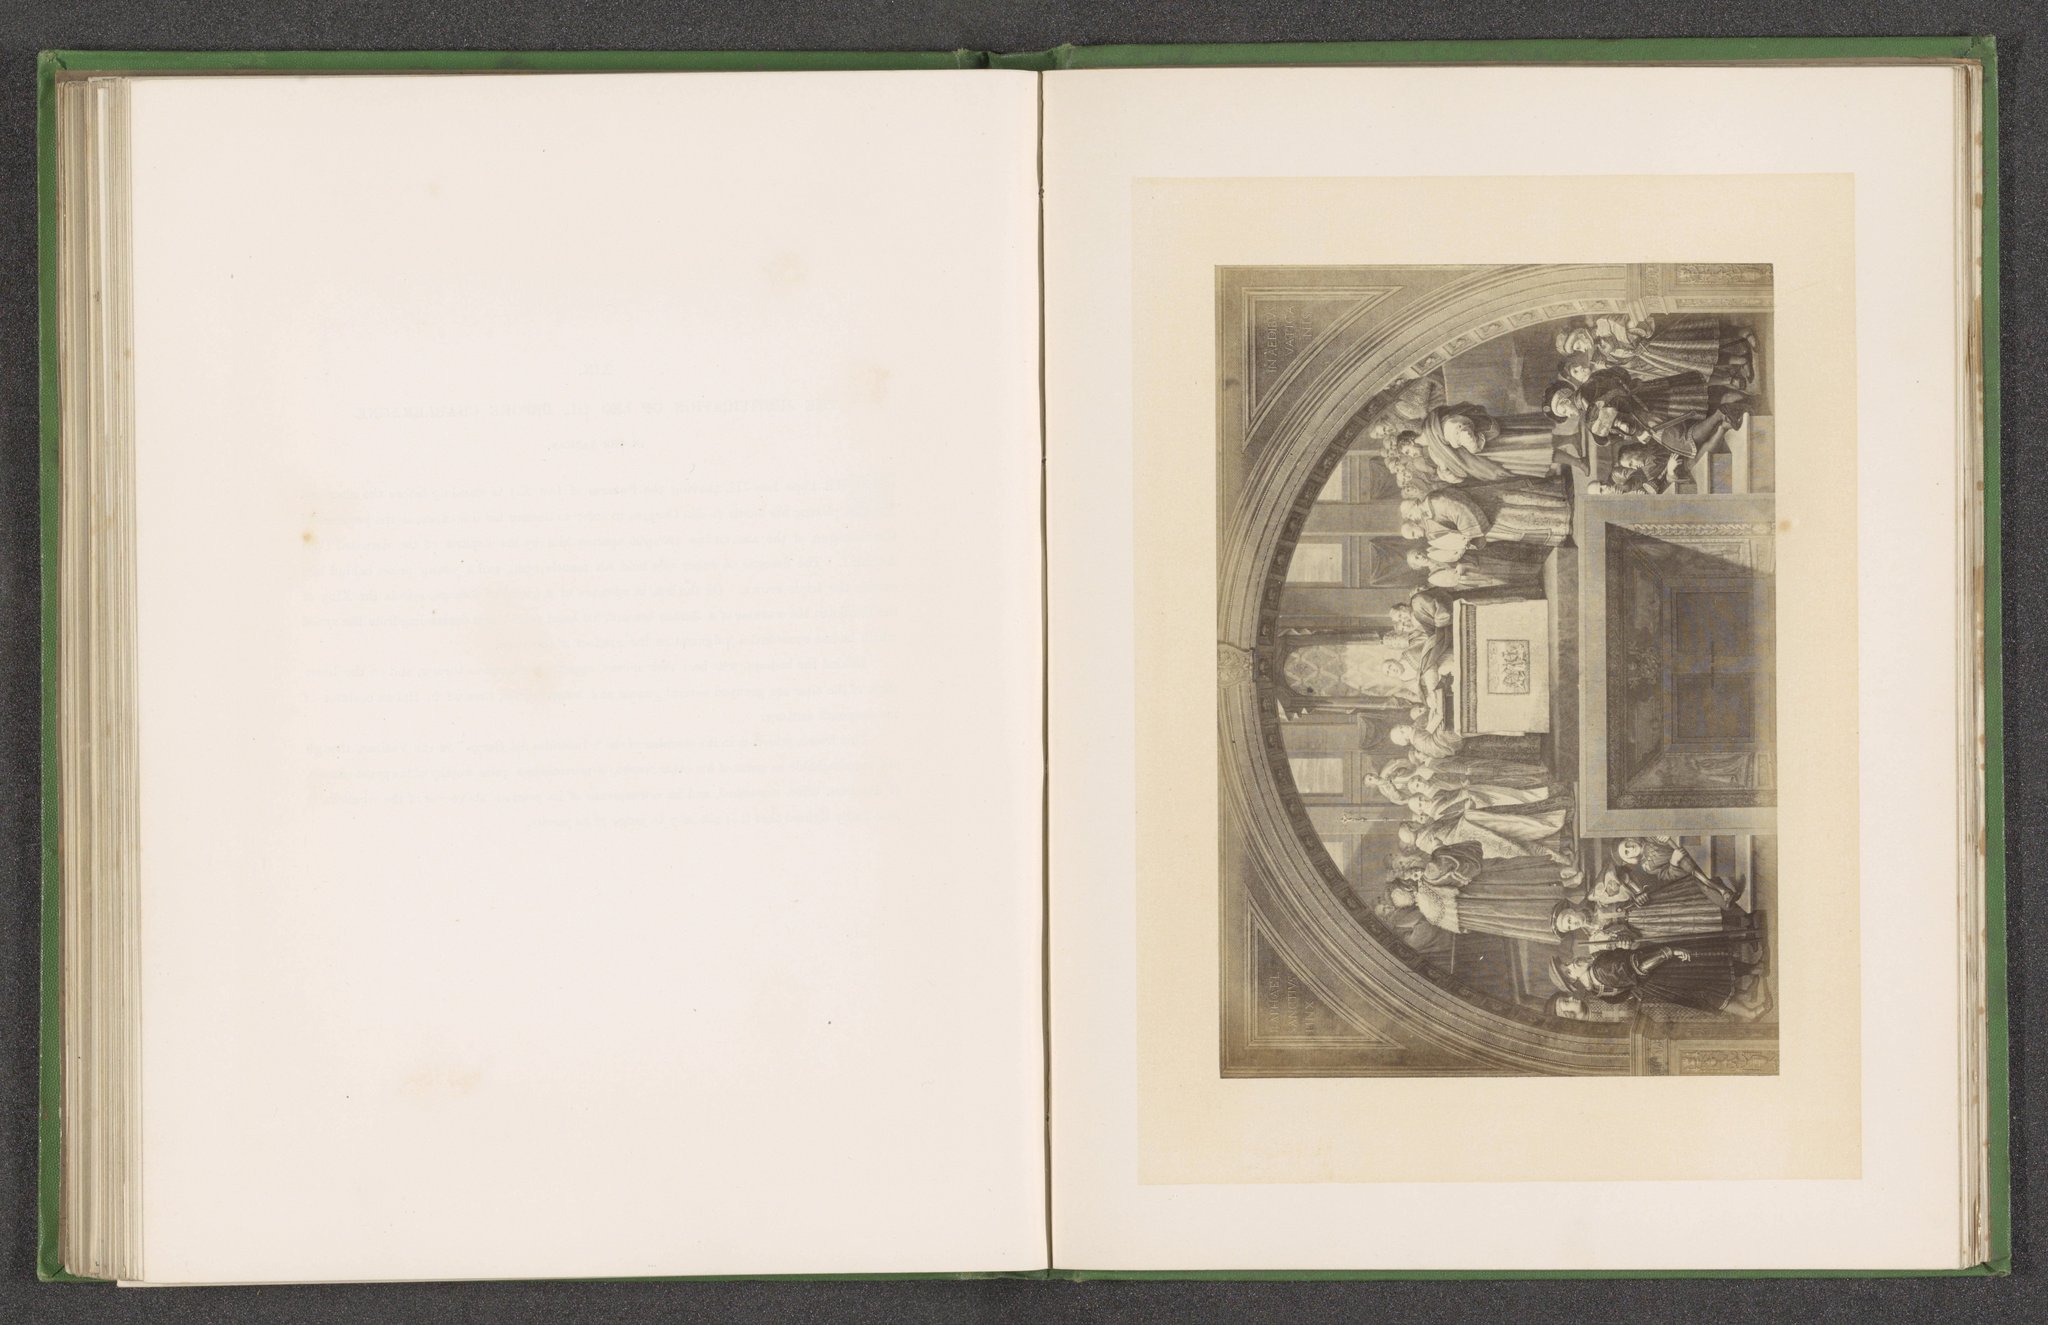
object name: reproduction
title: Fotoreproductie van een prent door A. Fabri van een fresco met de eed van Paus Leo III door Rafaël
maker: joseph cundall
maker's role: fotograaf, schrijver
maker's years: 1818-1895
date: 1859-1869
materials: photographic support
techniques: albumen print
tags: installation of a pope - pp - antipope